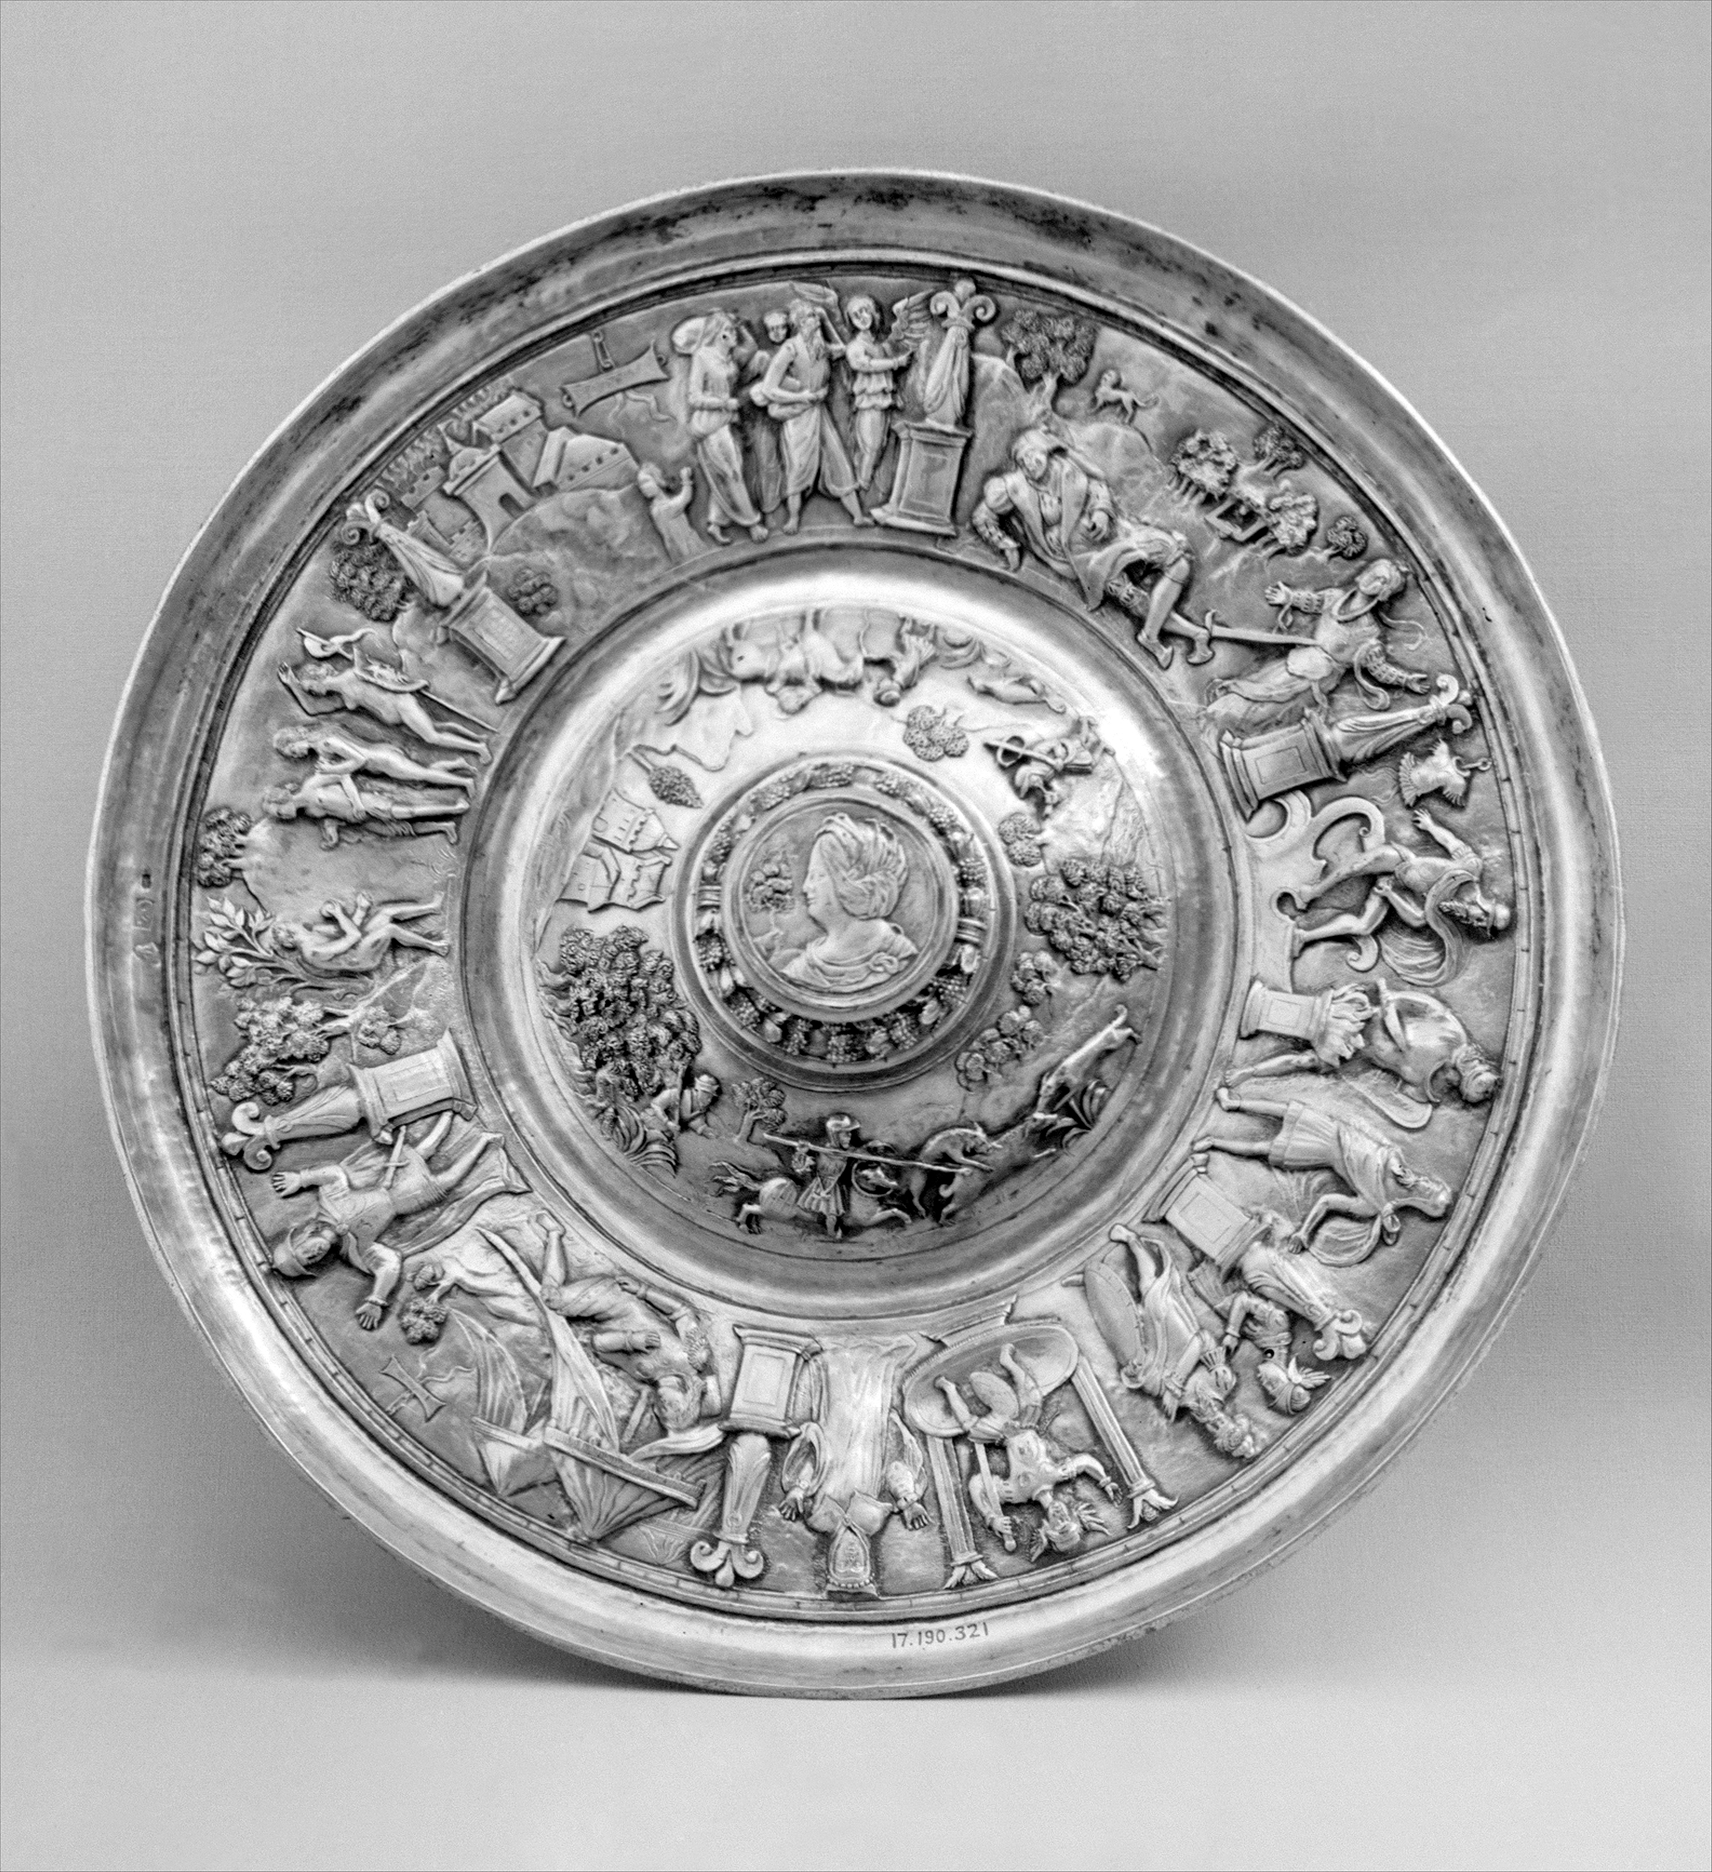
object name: plateau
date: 1537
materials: silver gilt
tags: profiles,women,hunting,trees